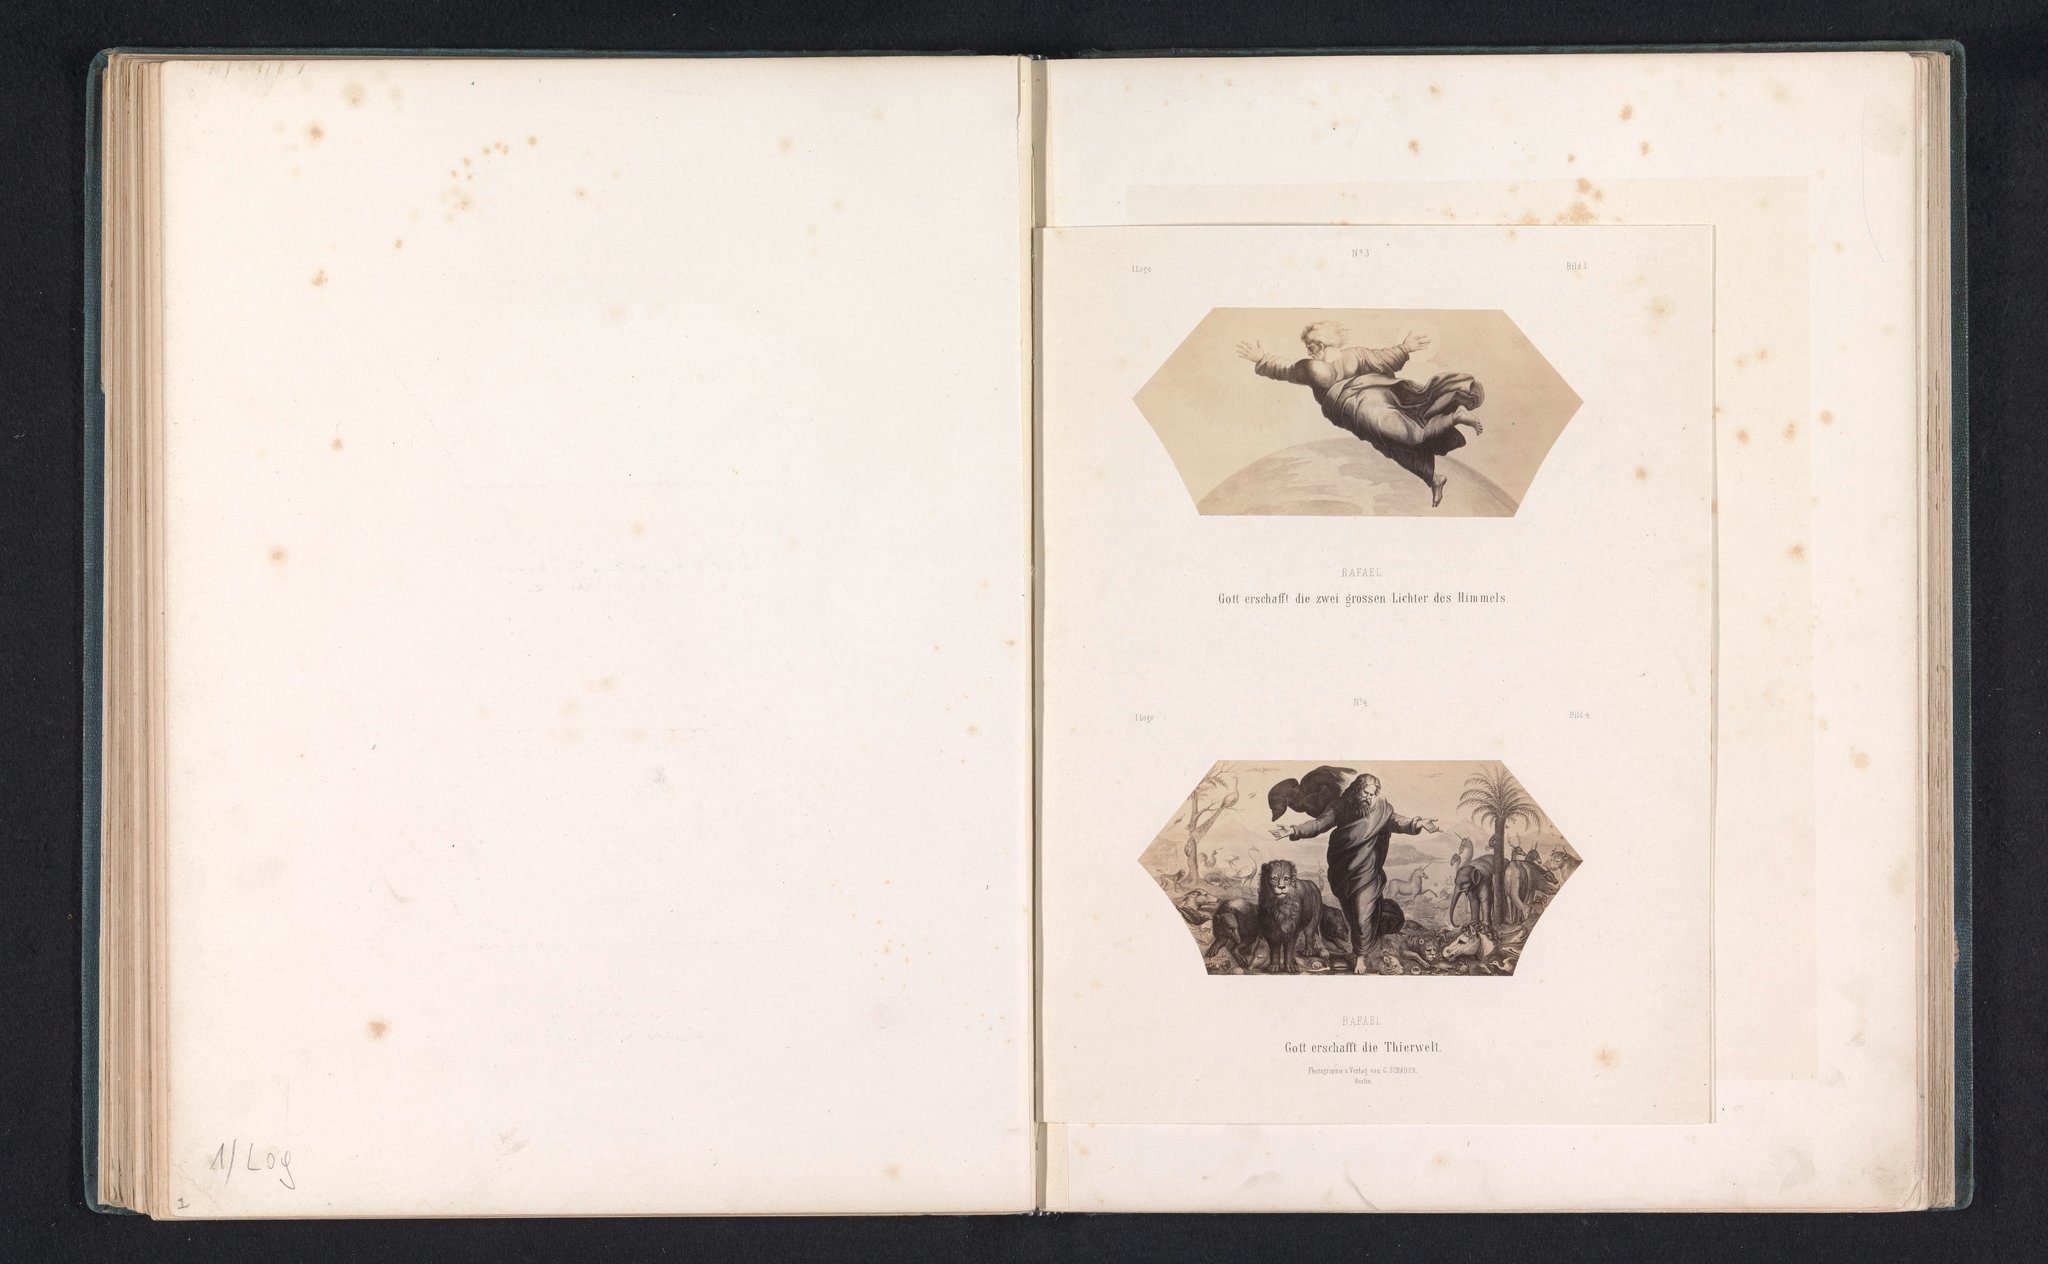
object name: reproduction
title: Fotoreproducties van prenten naar fresco's met voorstellingen van god door Rafaël voor de loggia's in het Vaticaan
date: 1851-1861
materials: photographic support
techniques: albumen print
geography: berlin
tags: creation of the animals ~ genesis, creation of sun, moon and stars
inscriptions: number: ‘Bild 3. Bild 4. I. Loge’